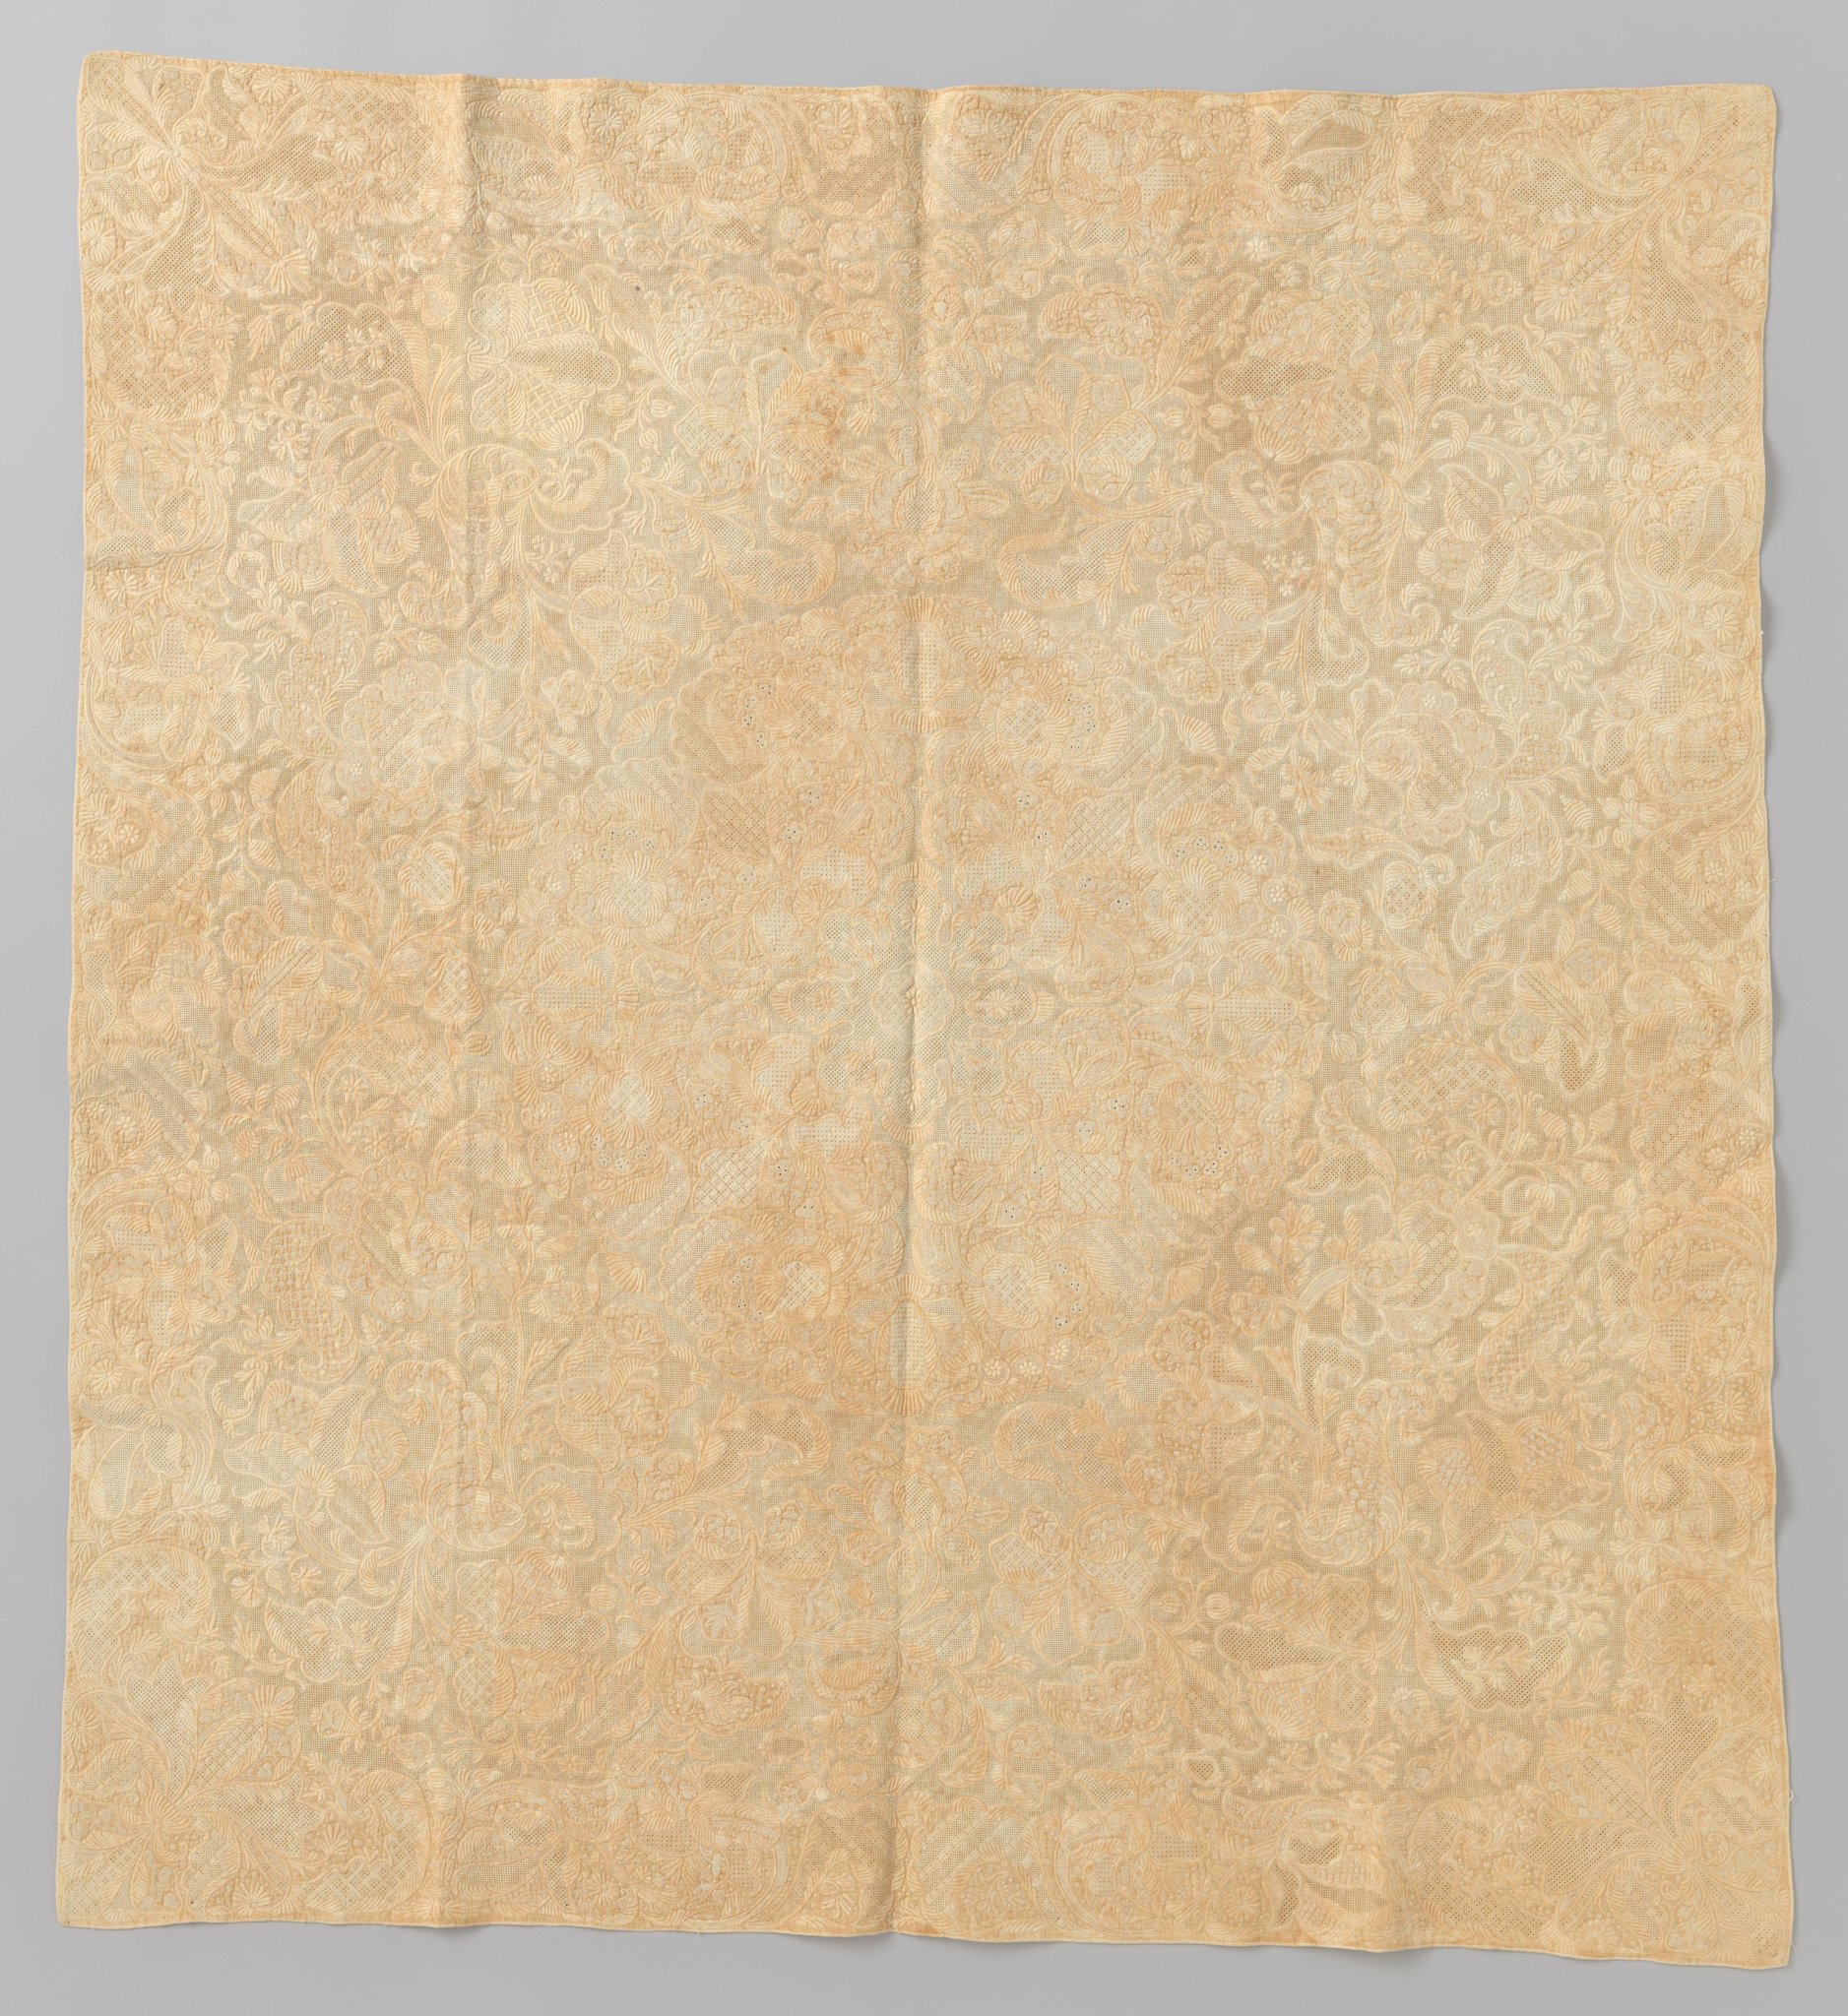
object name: bed covering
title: Katoenen sprei met Zaans stikwerk en borduurwerk; fils tirés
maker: Anonymous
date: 1700-1899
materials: cotton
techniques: embroidered, quilting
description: Katoenen sprei met borduurwerk en stikwerk. In het midden heeft het patroon een cirkel waarbinnen een overhoeks kwadraat waar omheen vier palmetten, onderling gescheiden door een schelp en een pijnappel. Rondom de cirkel is de grond gevuld met bloemen en bladeren. In de hoeken heeft het patroon pijnappel motieven en bladeren.